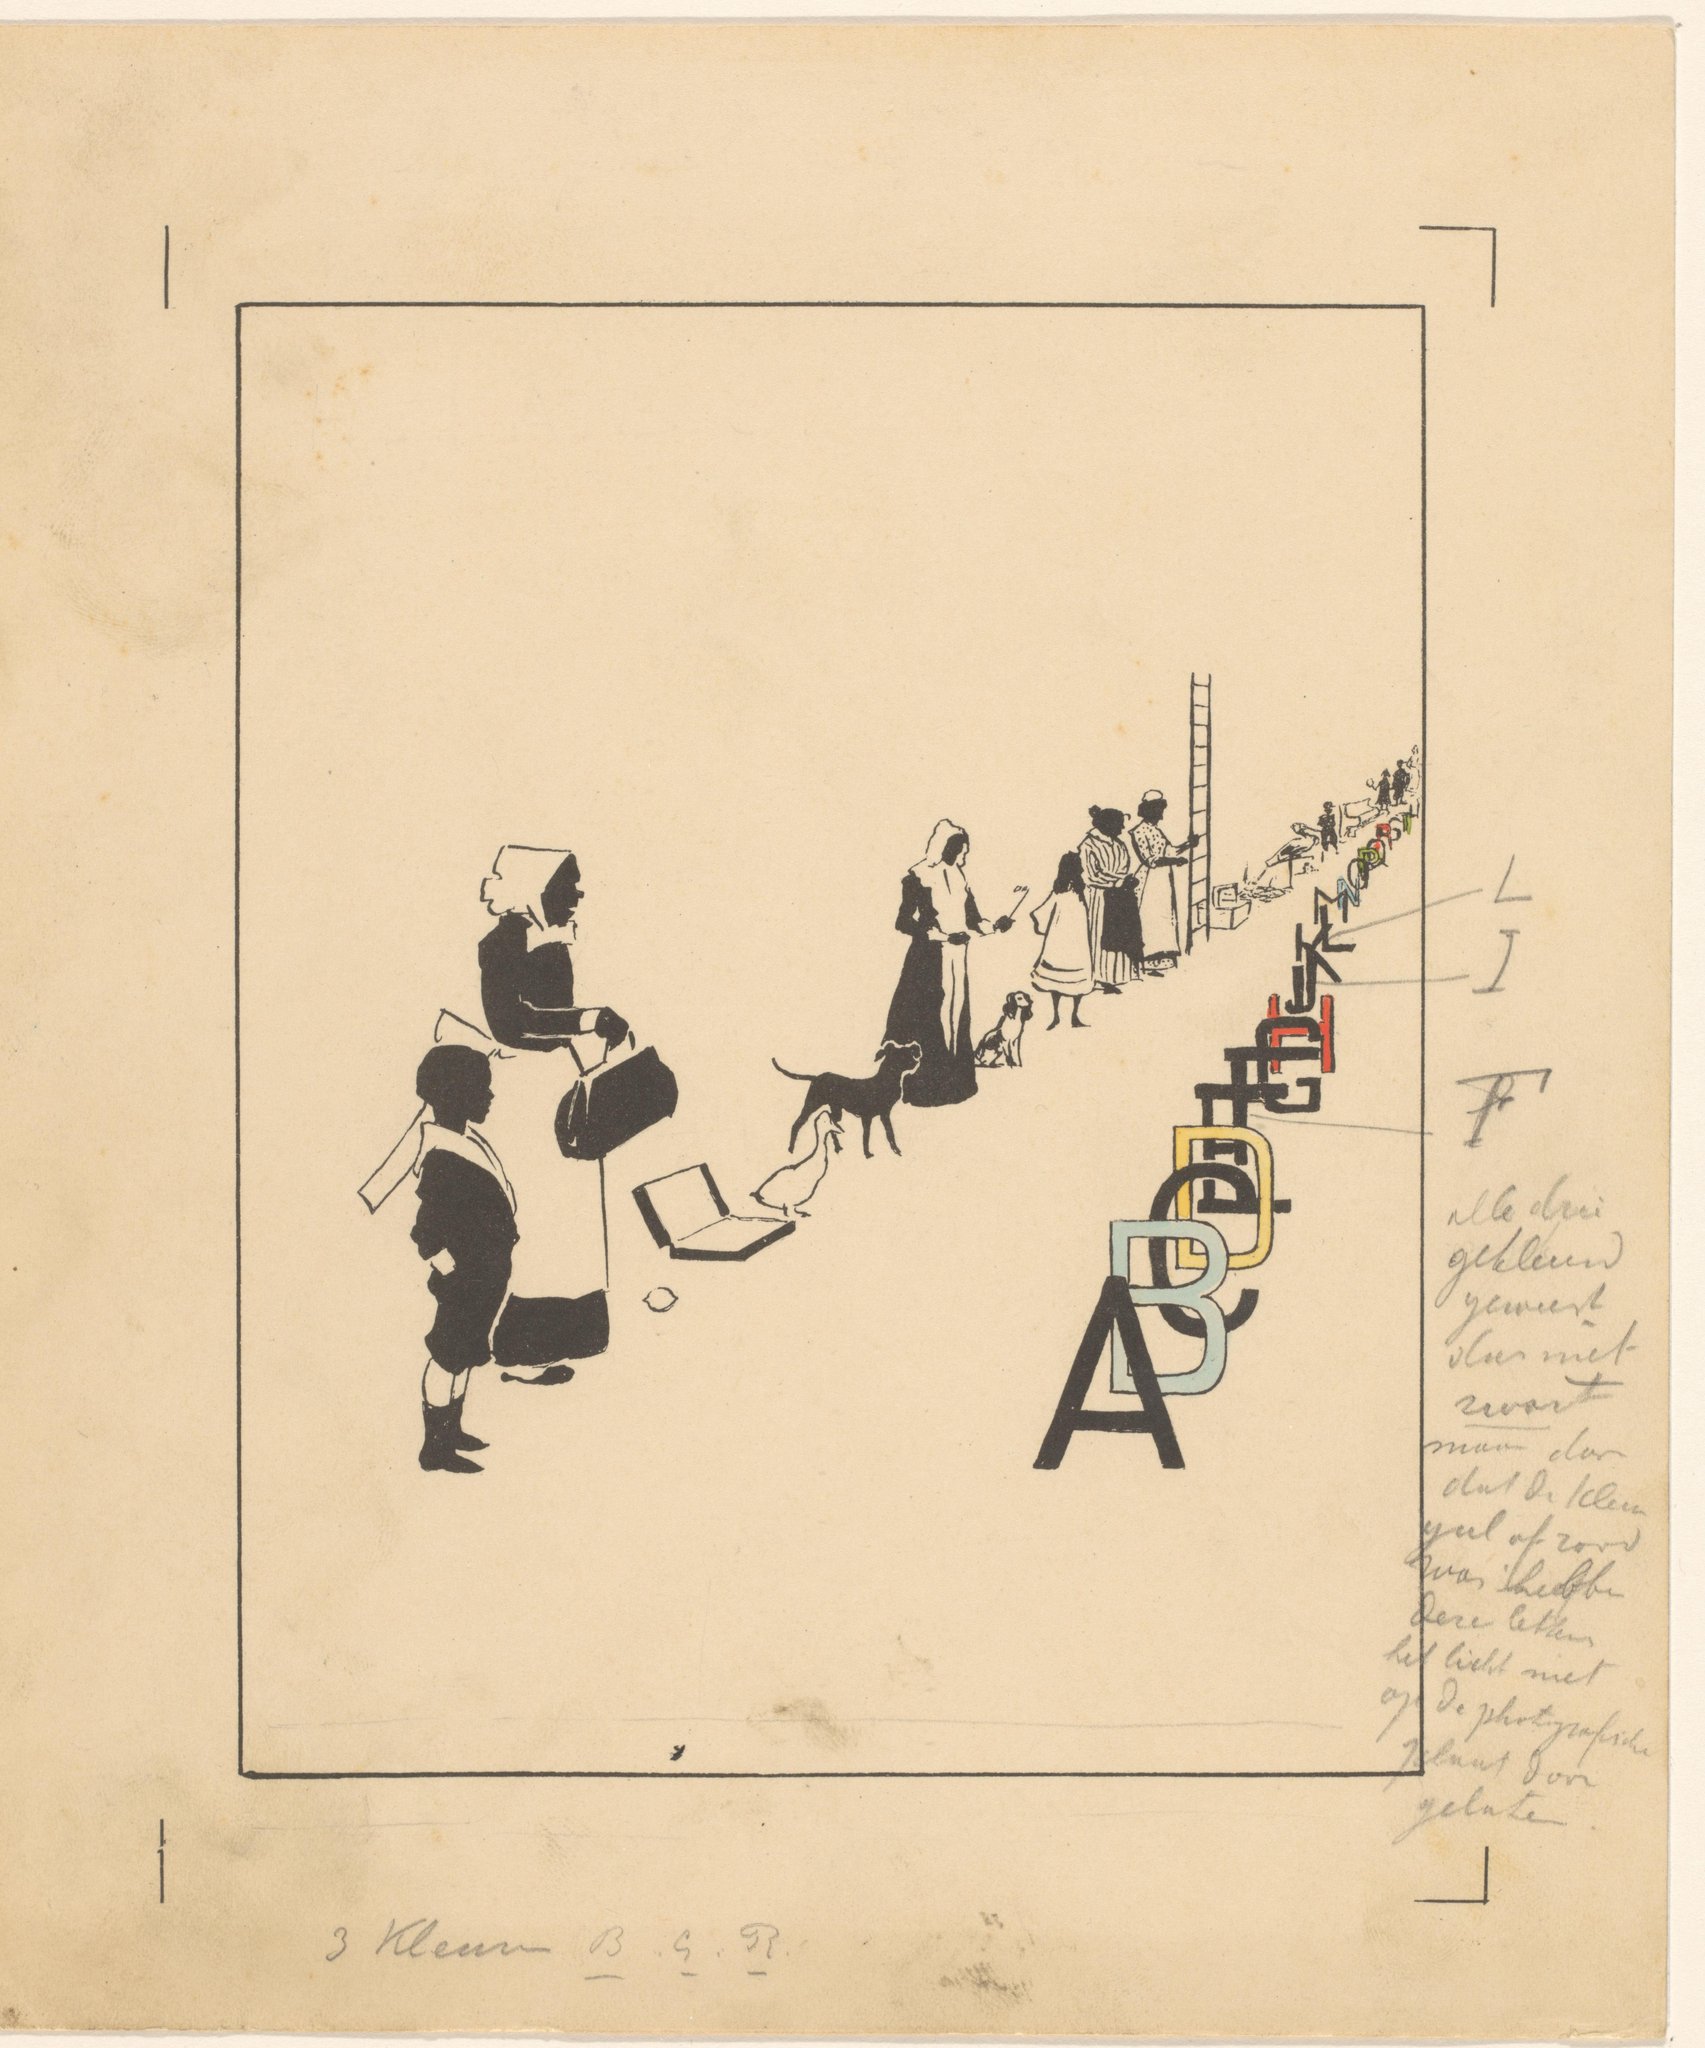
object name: drawing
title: Rijen met letters van het alfabet, mensen, dieren en voorwerpen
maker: Anonymous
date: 1880-1910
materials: ink, paper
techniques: brush, pen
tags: human life and its ages (young, adult, old, etc.), animals, letters, alphabet, script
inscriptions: :, collector's mark: Lugt 2228a